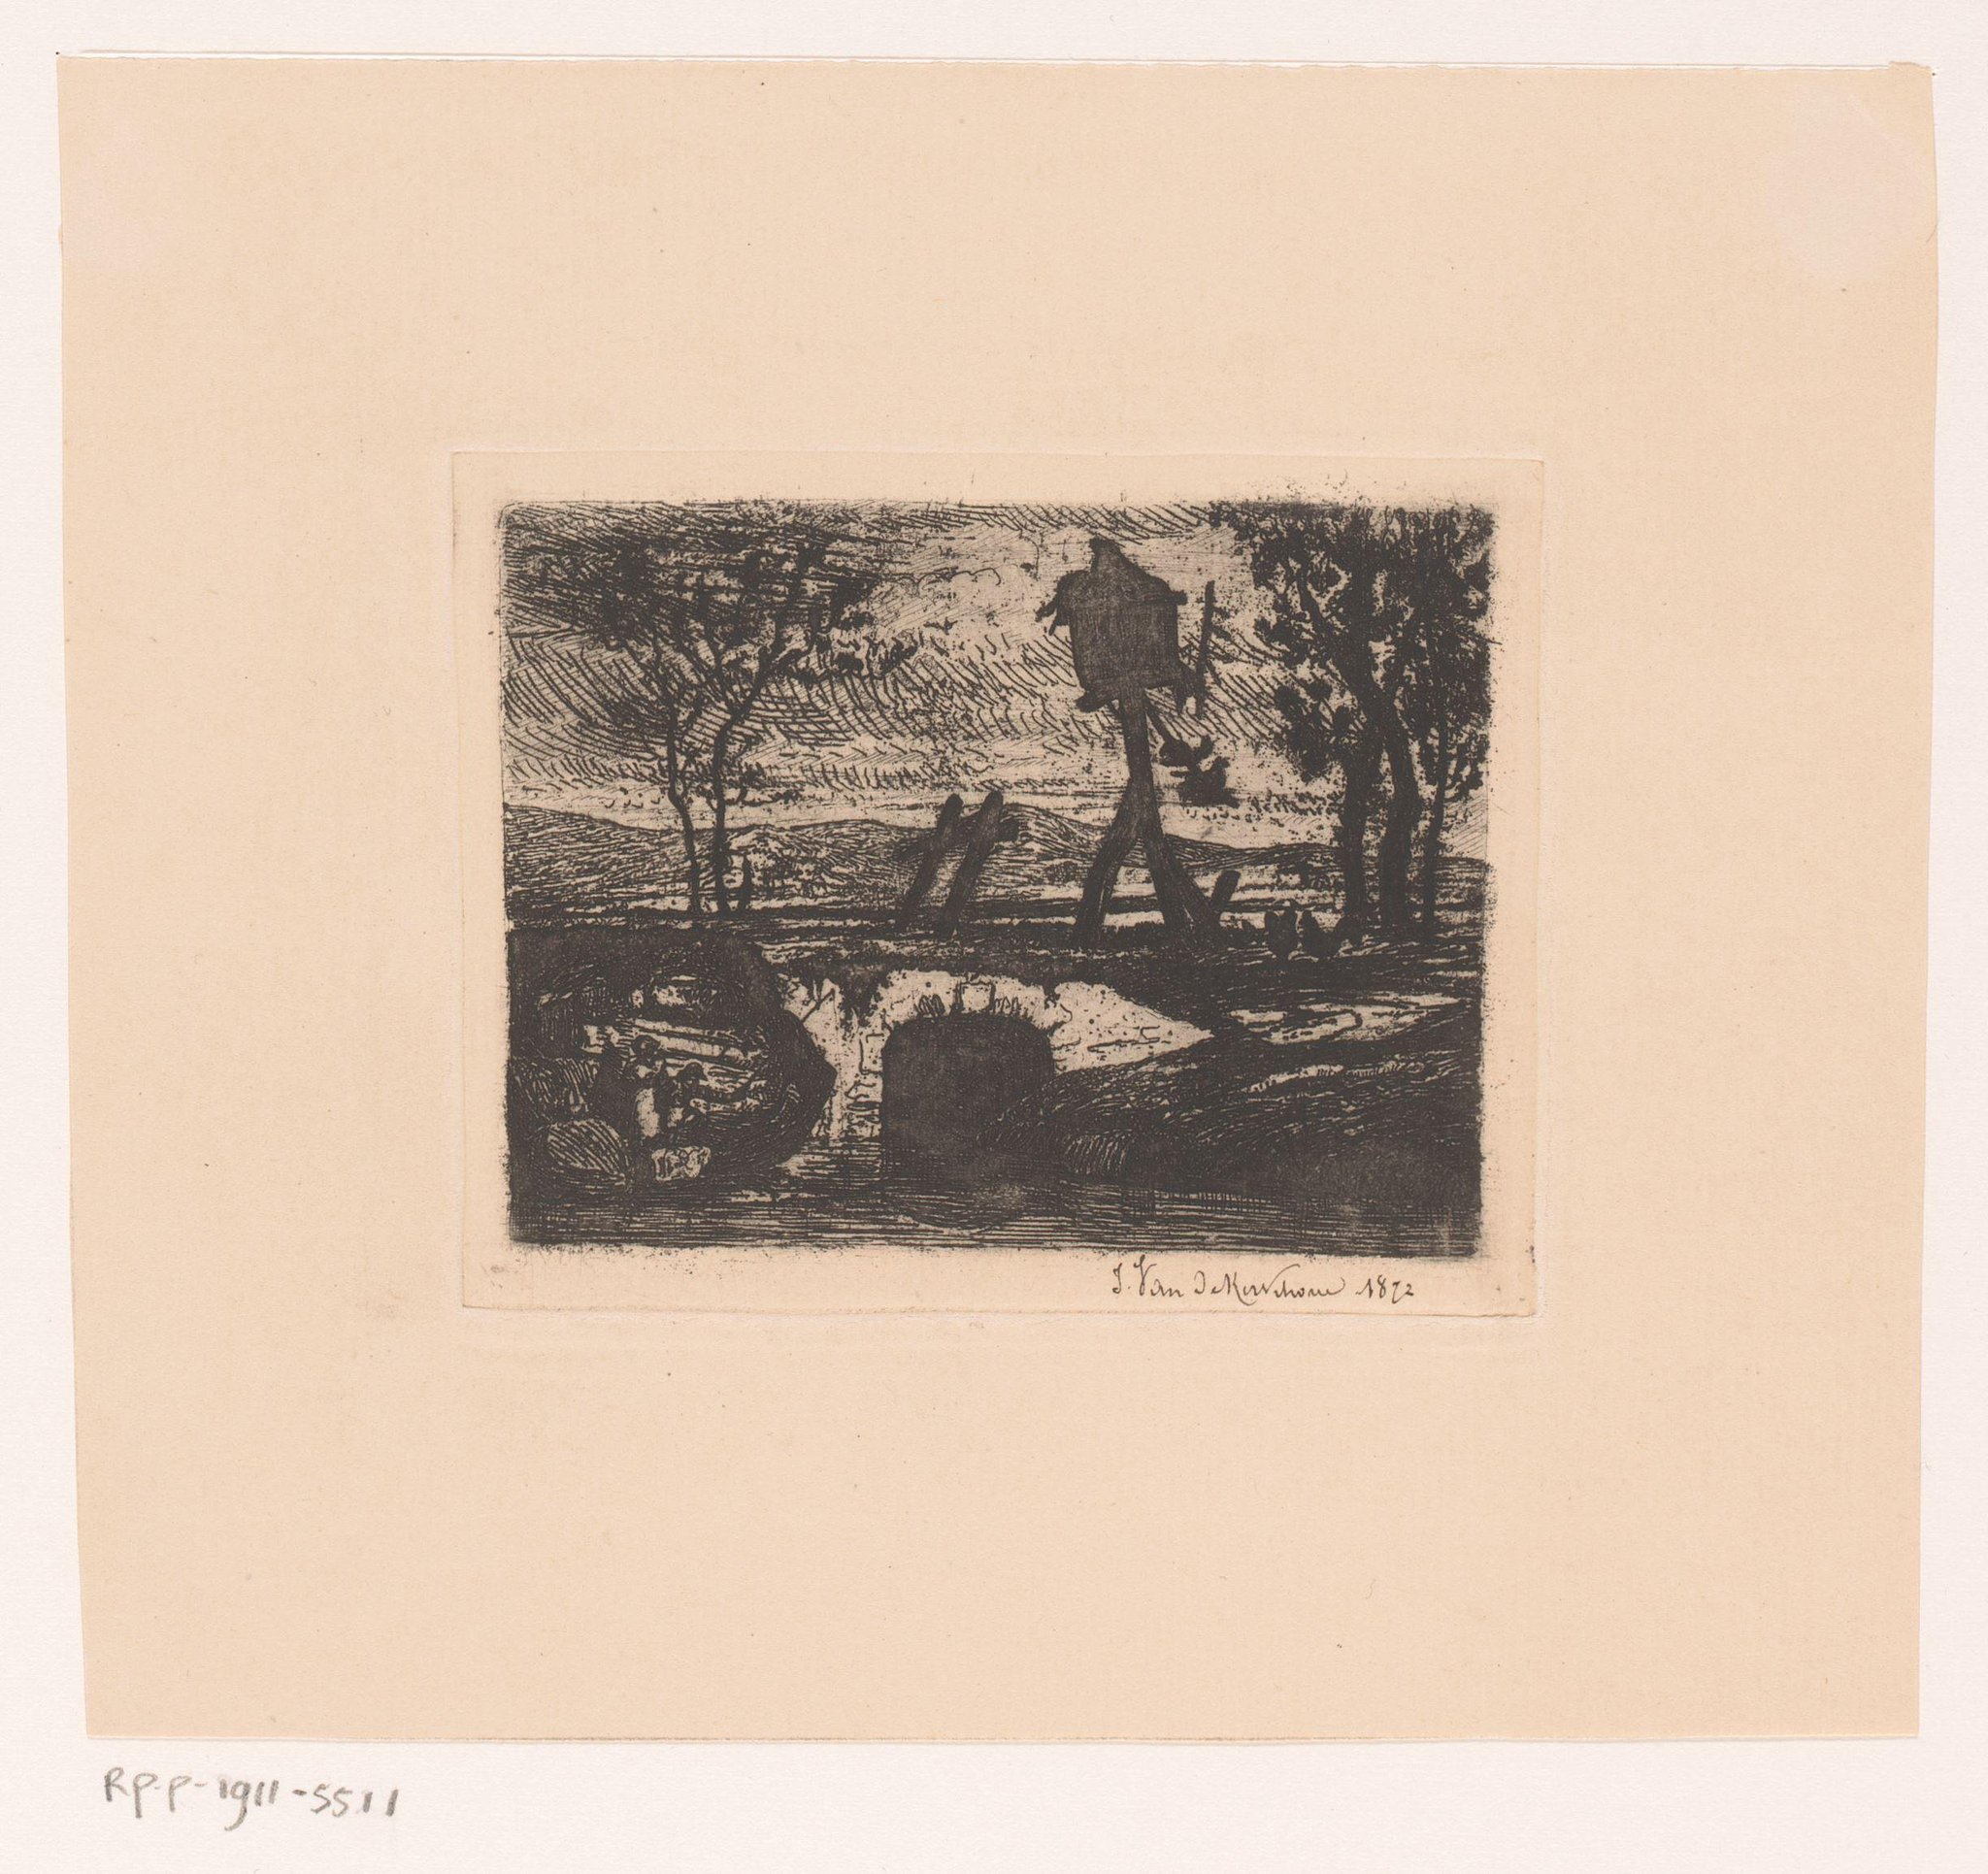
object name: print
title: Landschap met houten toren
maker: jan van de kerkhove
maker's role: print maker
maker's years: 1822-1881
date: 1872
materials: paper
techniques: drypoint, etching, intaglio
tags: landscapes (+ landscape with figures, staffage)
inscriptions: collector's mark: Lugt 2228